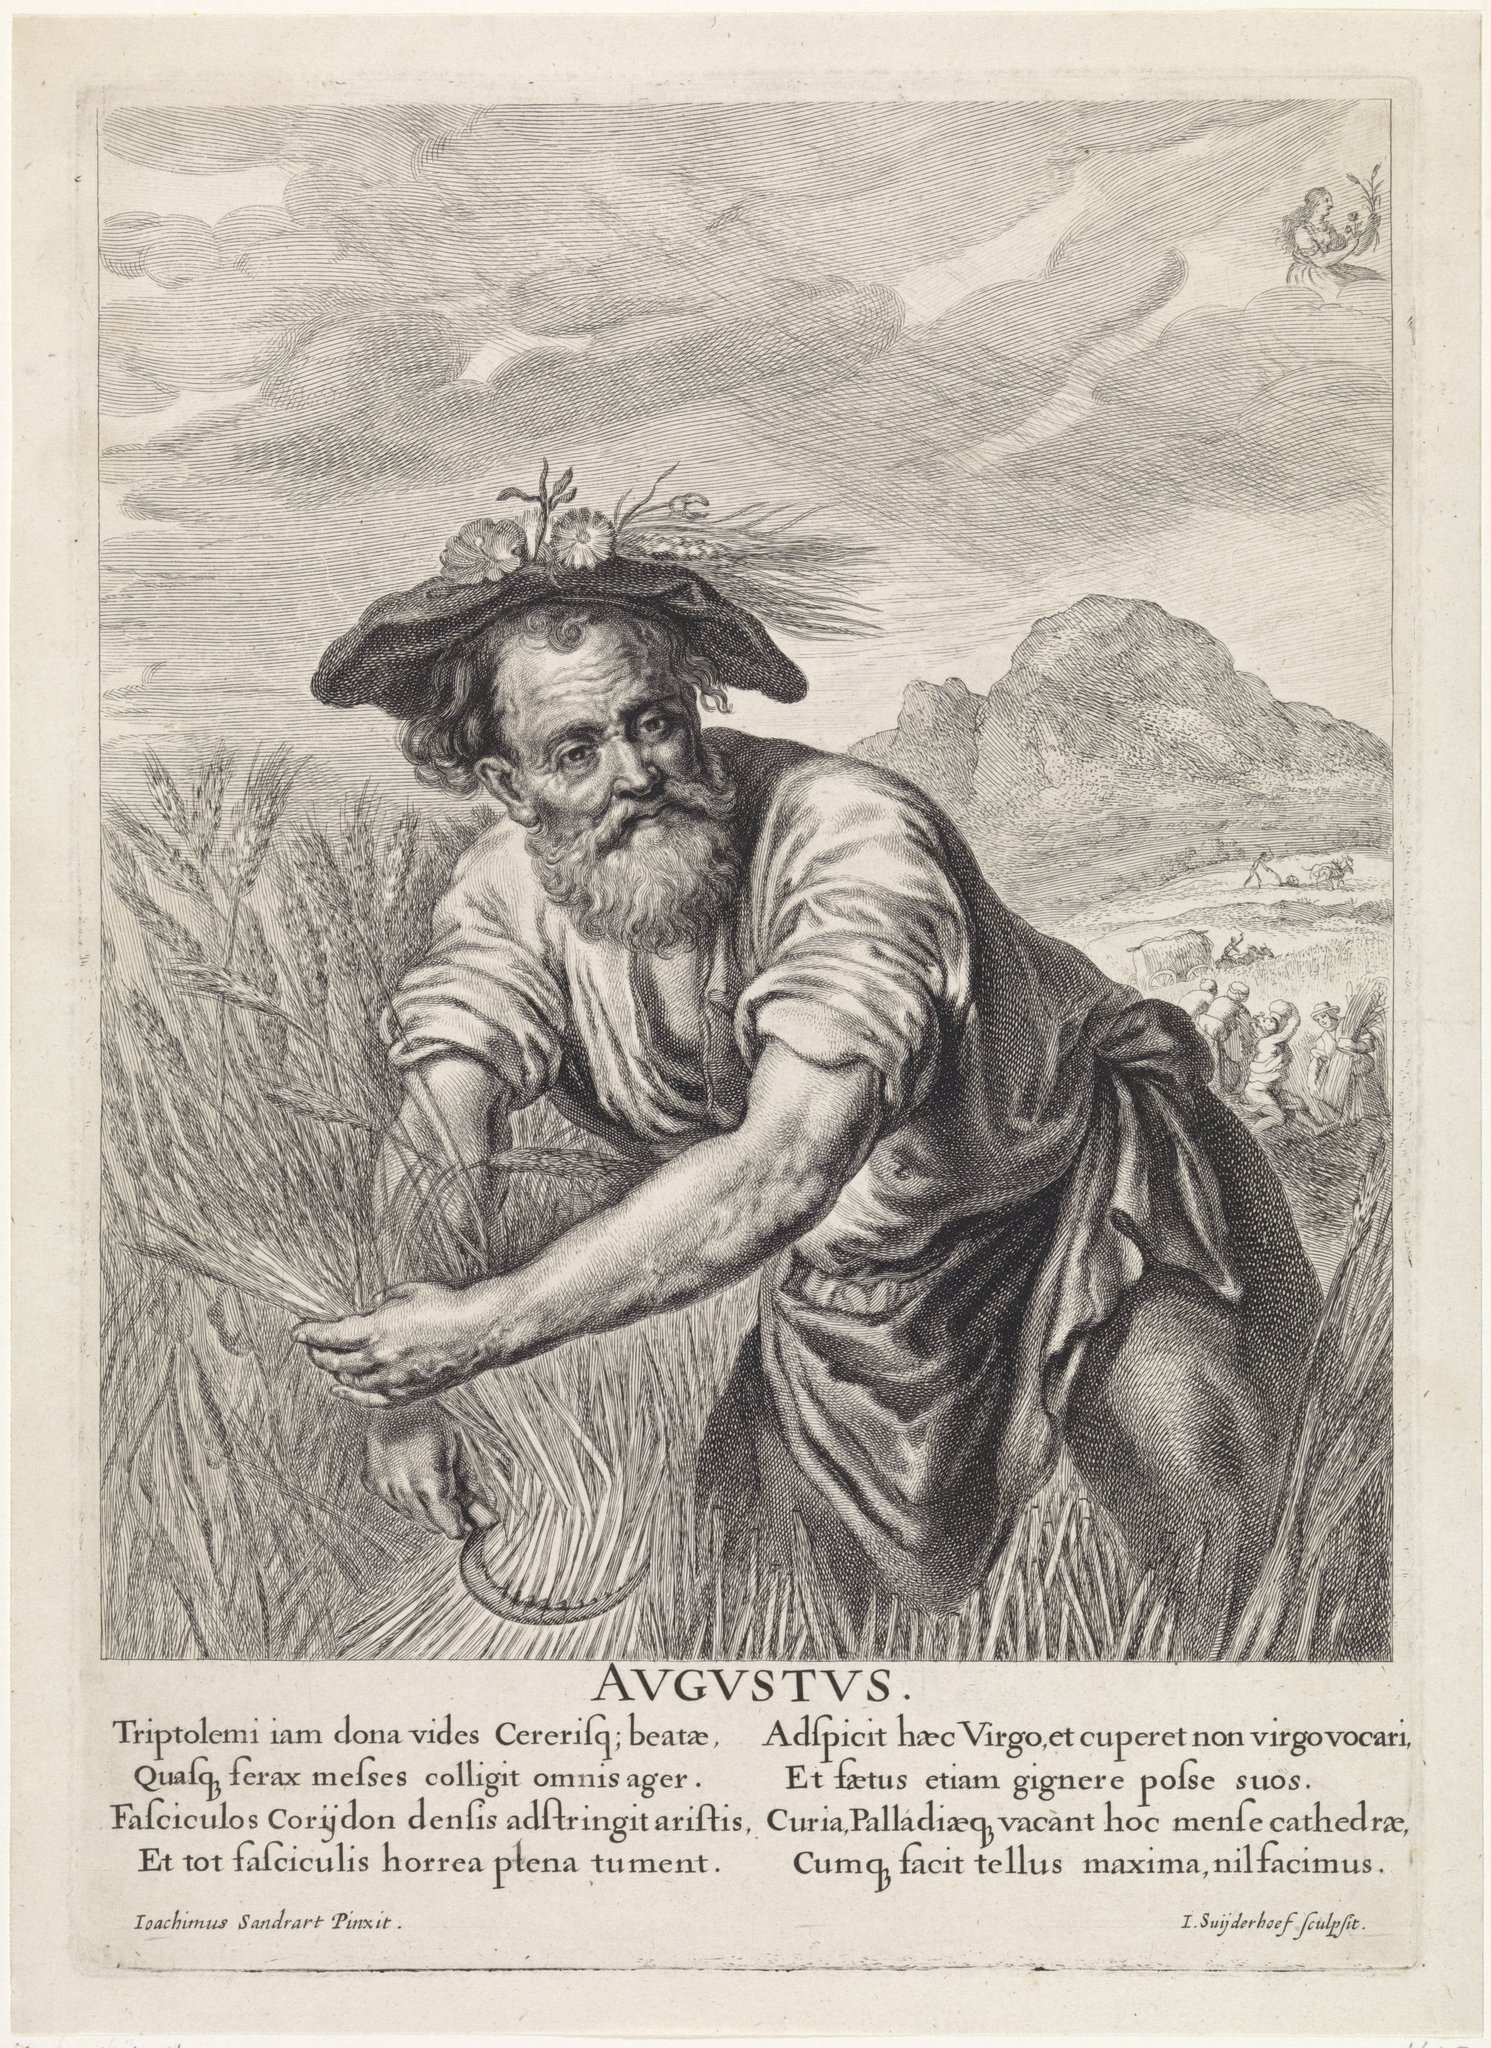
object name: print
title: Augustus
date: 1645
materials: paper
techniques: engraving, etching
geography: amsterdam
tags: virgo (zodiacal sign of august), harvest, august and its 'labours', august; 'agosto' (ripa)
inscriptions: collector's mark: Lugt 240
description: Een boer zet zijn sikkel in het koren. Op zijn hoofd een baret versierd met korenbloemen, klaprozen en korenaren. Op de achtergrond oogstende boeren, een wagen en een drinkende figuur. Aan de hemel het sterrenbeeld maagd. Onder de voorstelling een vers in Latijn van twee keer vier regels.